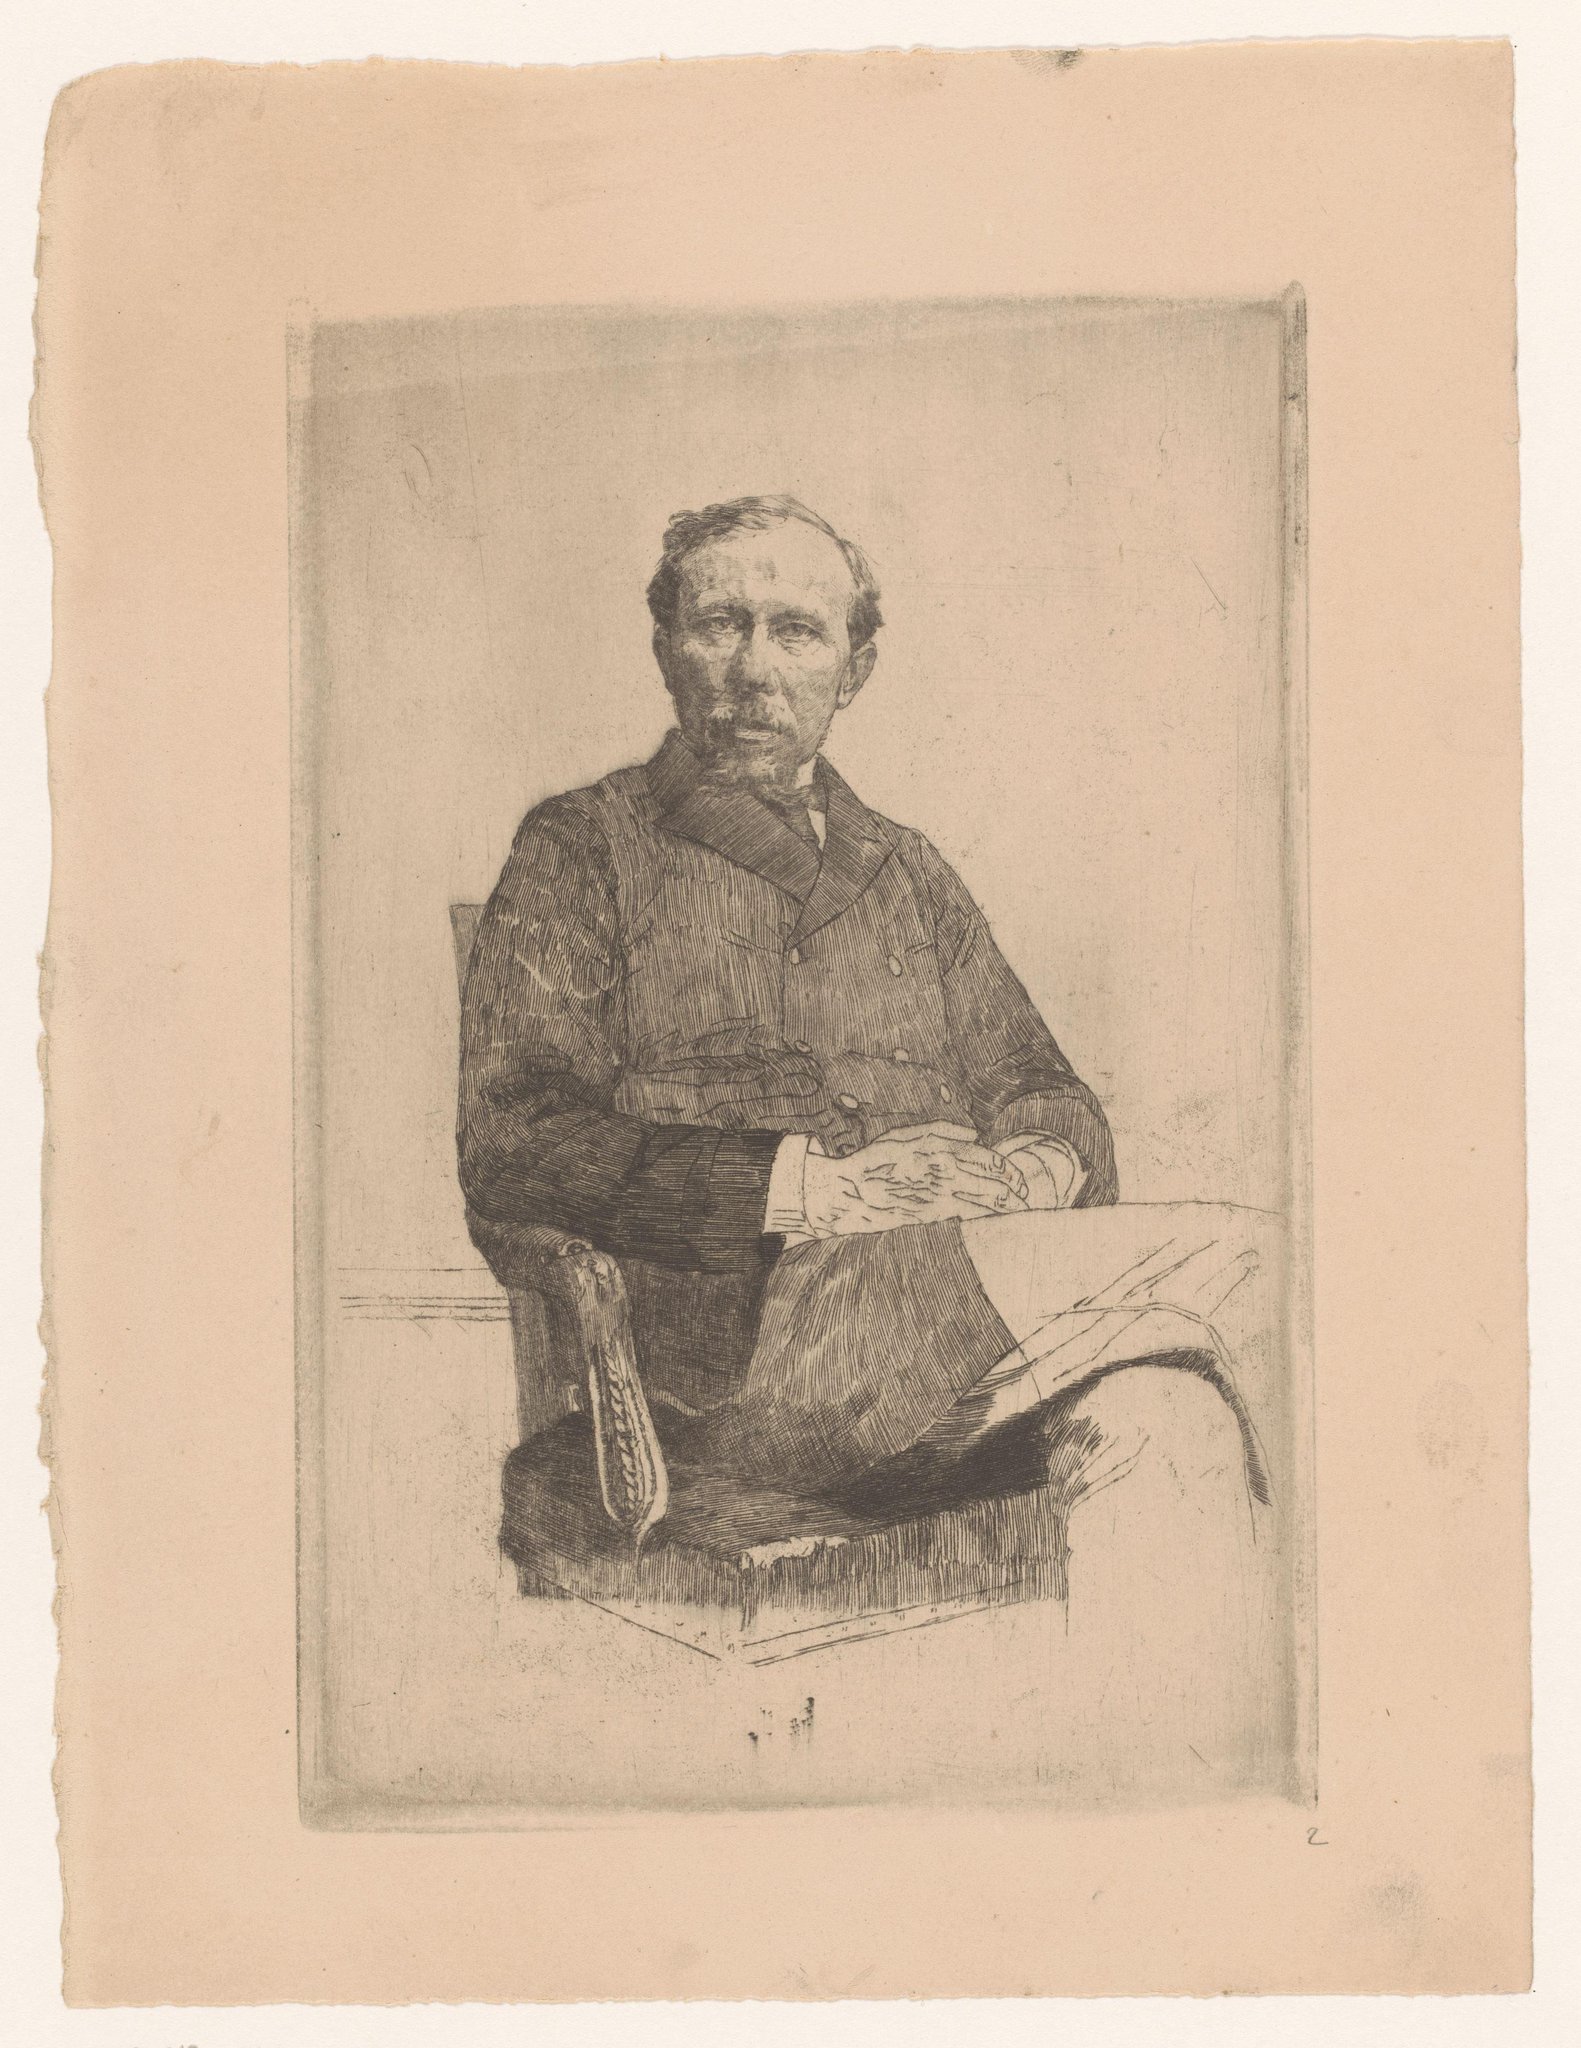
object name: print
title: Portret van een onbekende man gezeten in een stoel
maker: adrien de witte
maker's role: print maker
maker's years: 1850-1935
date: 1860-1913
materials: paper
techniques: etching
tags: sitting figure, adult man, historical persons, beard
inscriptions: collector's mark: Lugt 2228